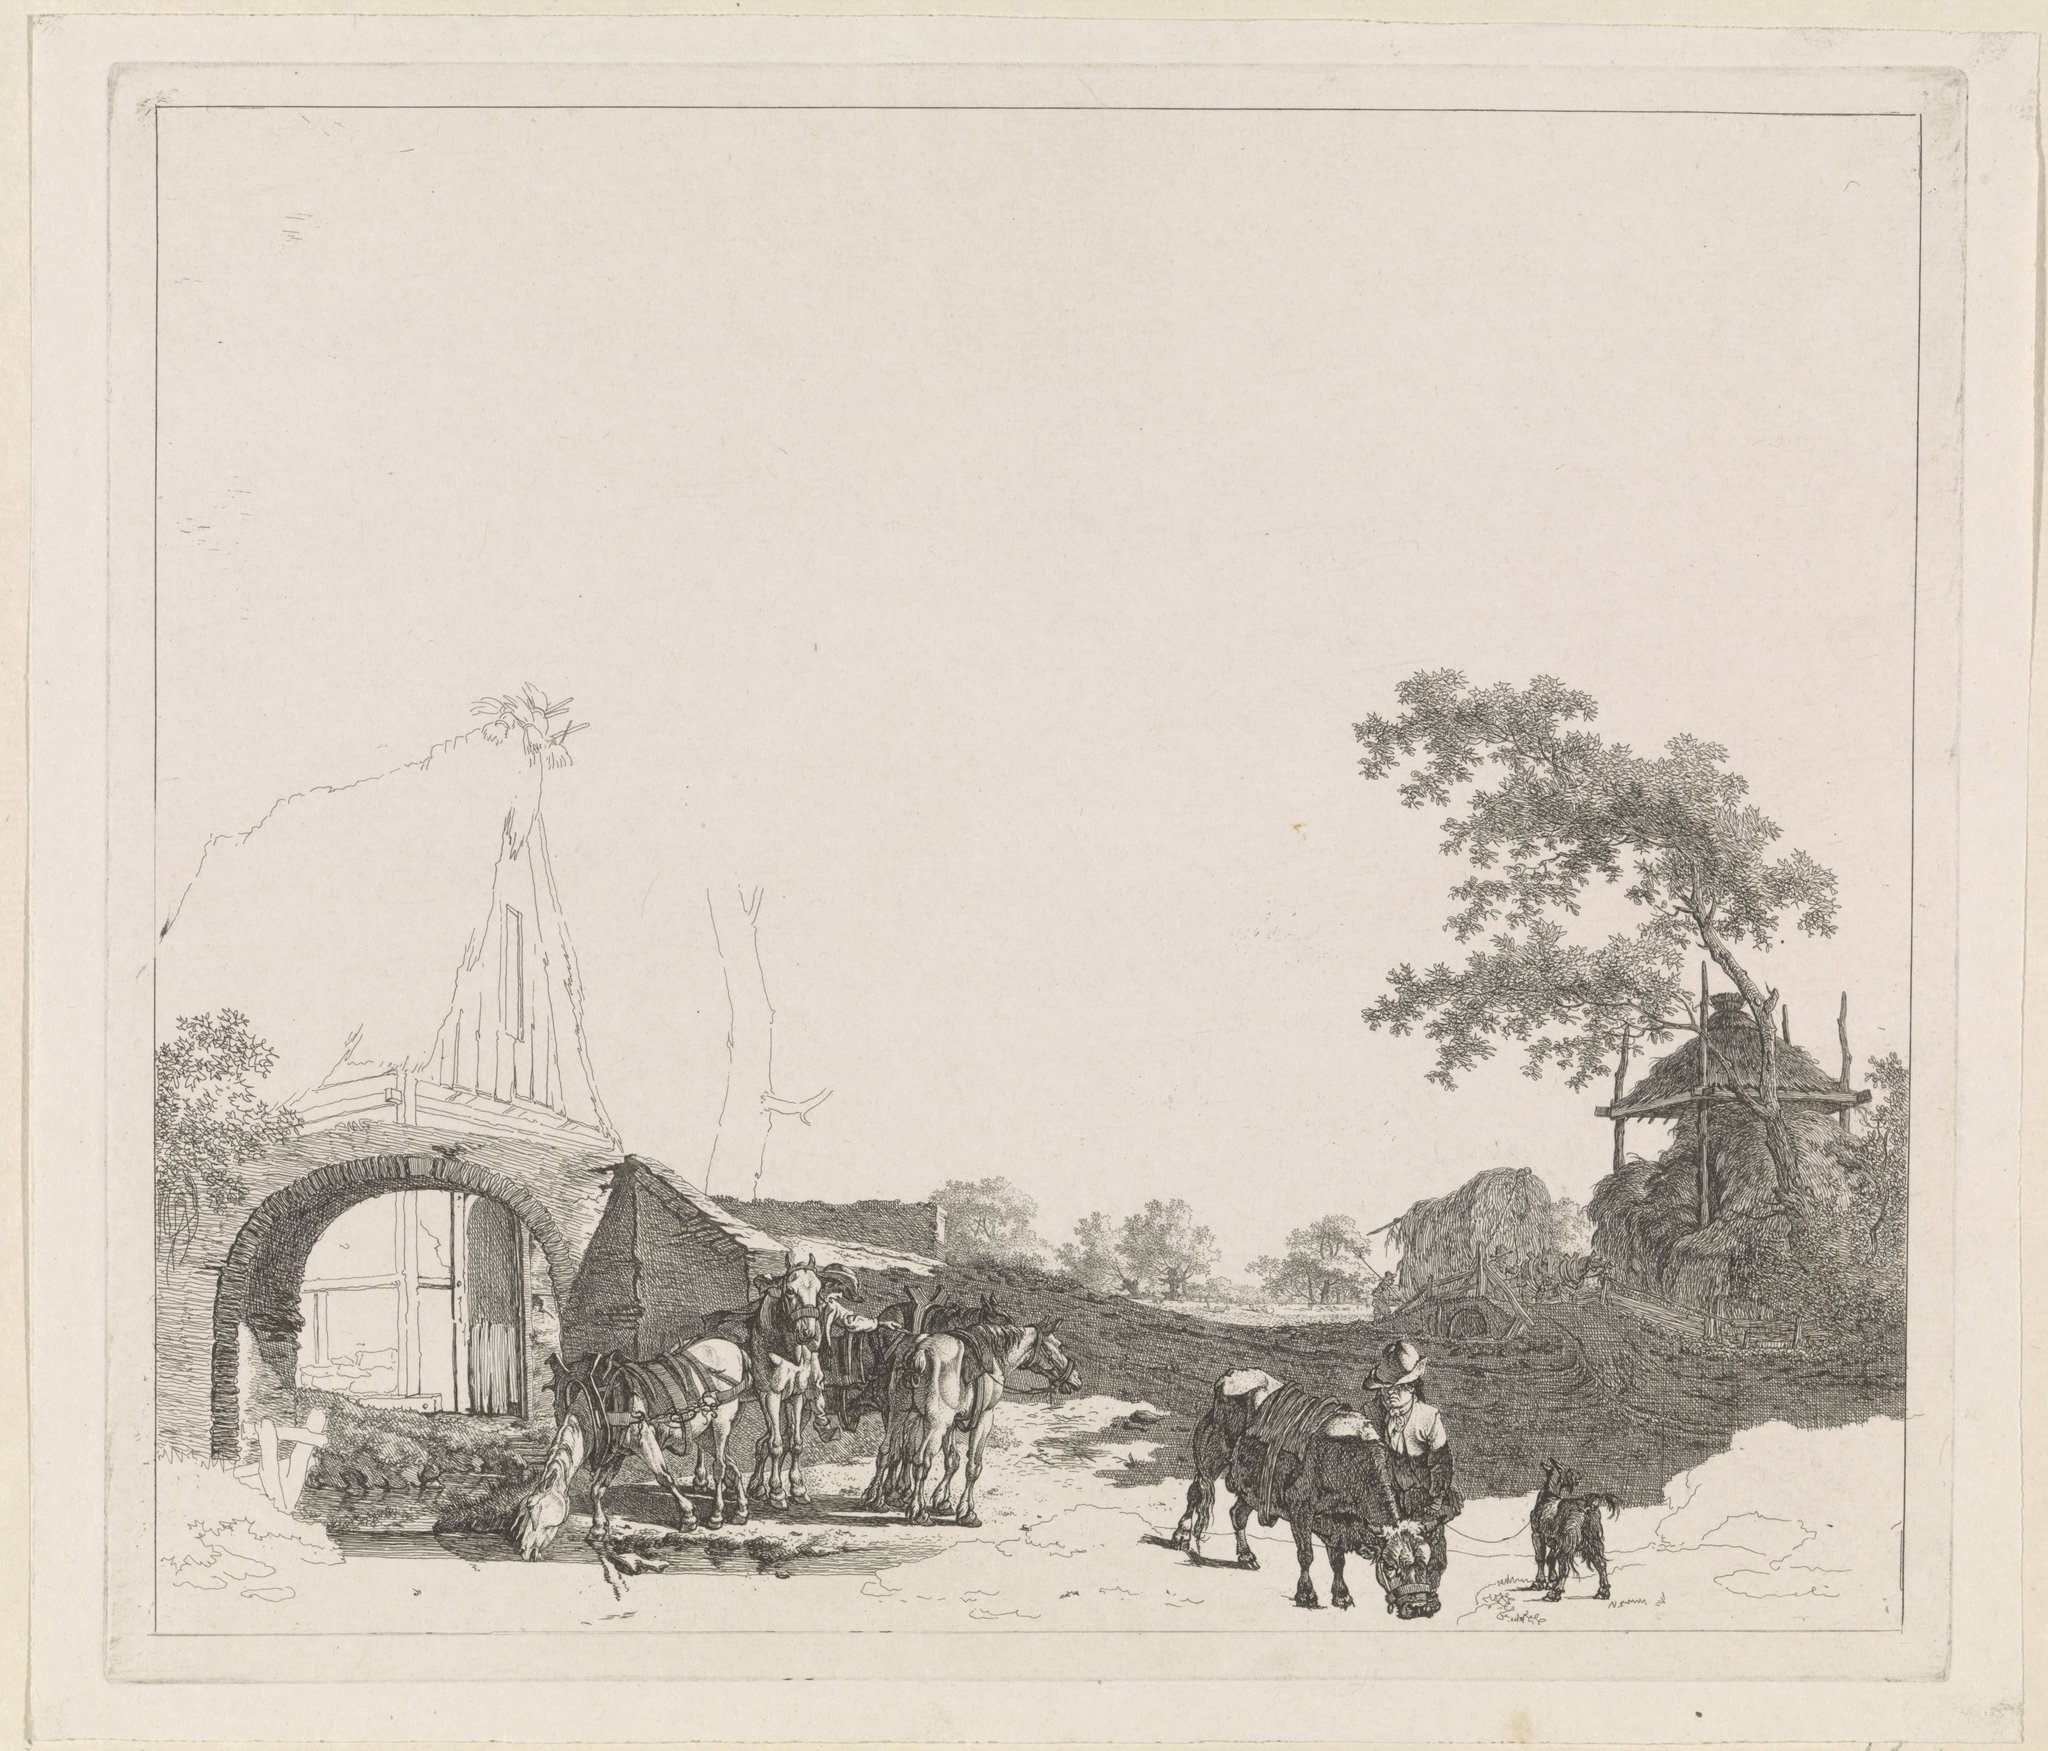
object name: print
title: Boeren met paarden en ander vee bij een beek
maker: barend hendrik thier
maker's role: draughtsman, print maker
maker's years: 1743-1811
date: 1780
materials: paper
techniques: etching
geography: netherlands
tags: cow, horse, giving water, feeding (cattle), hay-stack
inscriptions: collector's mark: Lugt 240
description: Landschap met twee boeren, die een paard en een rund laten drinken uit een beek. Rechts een hooiberg.